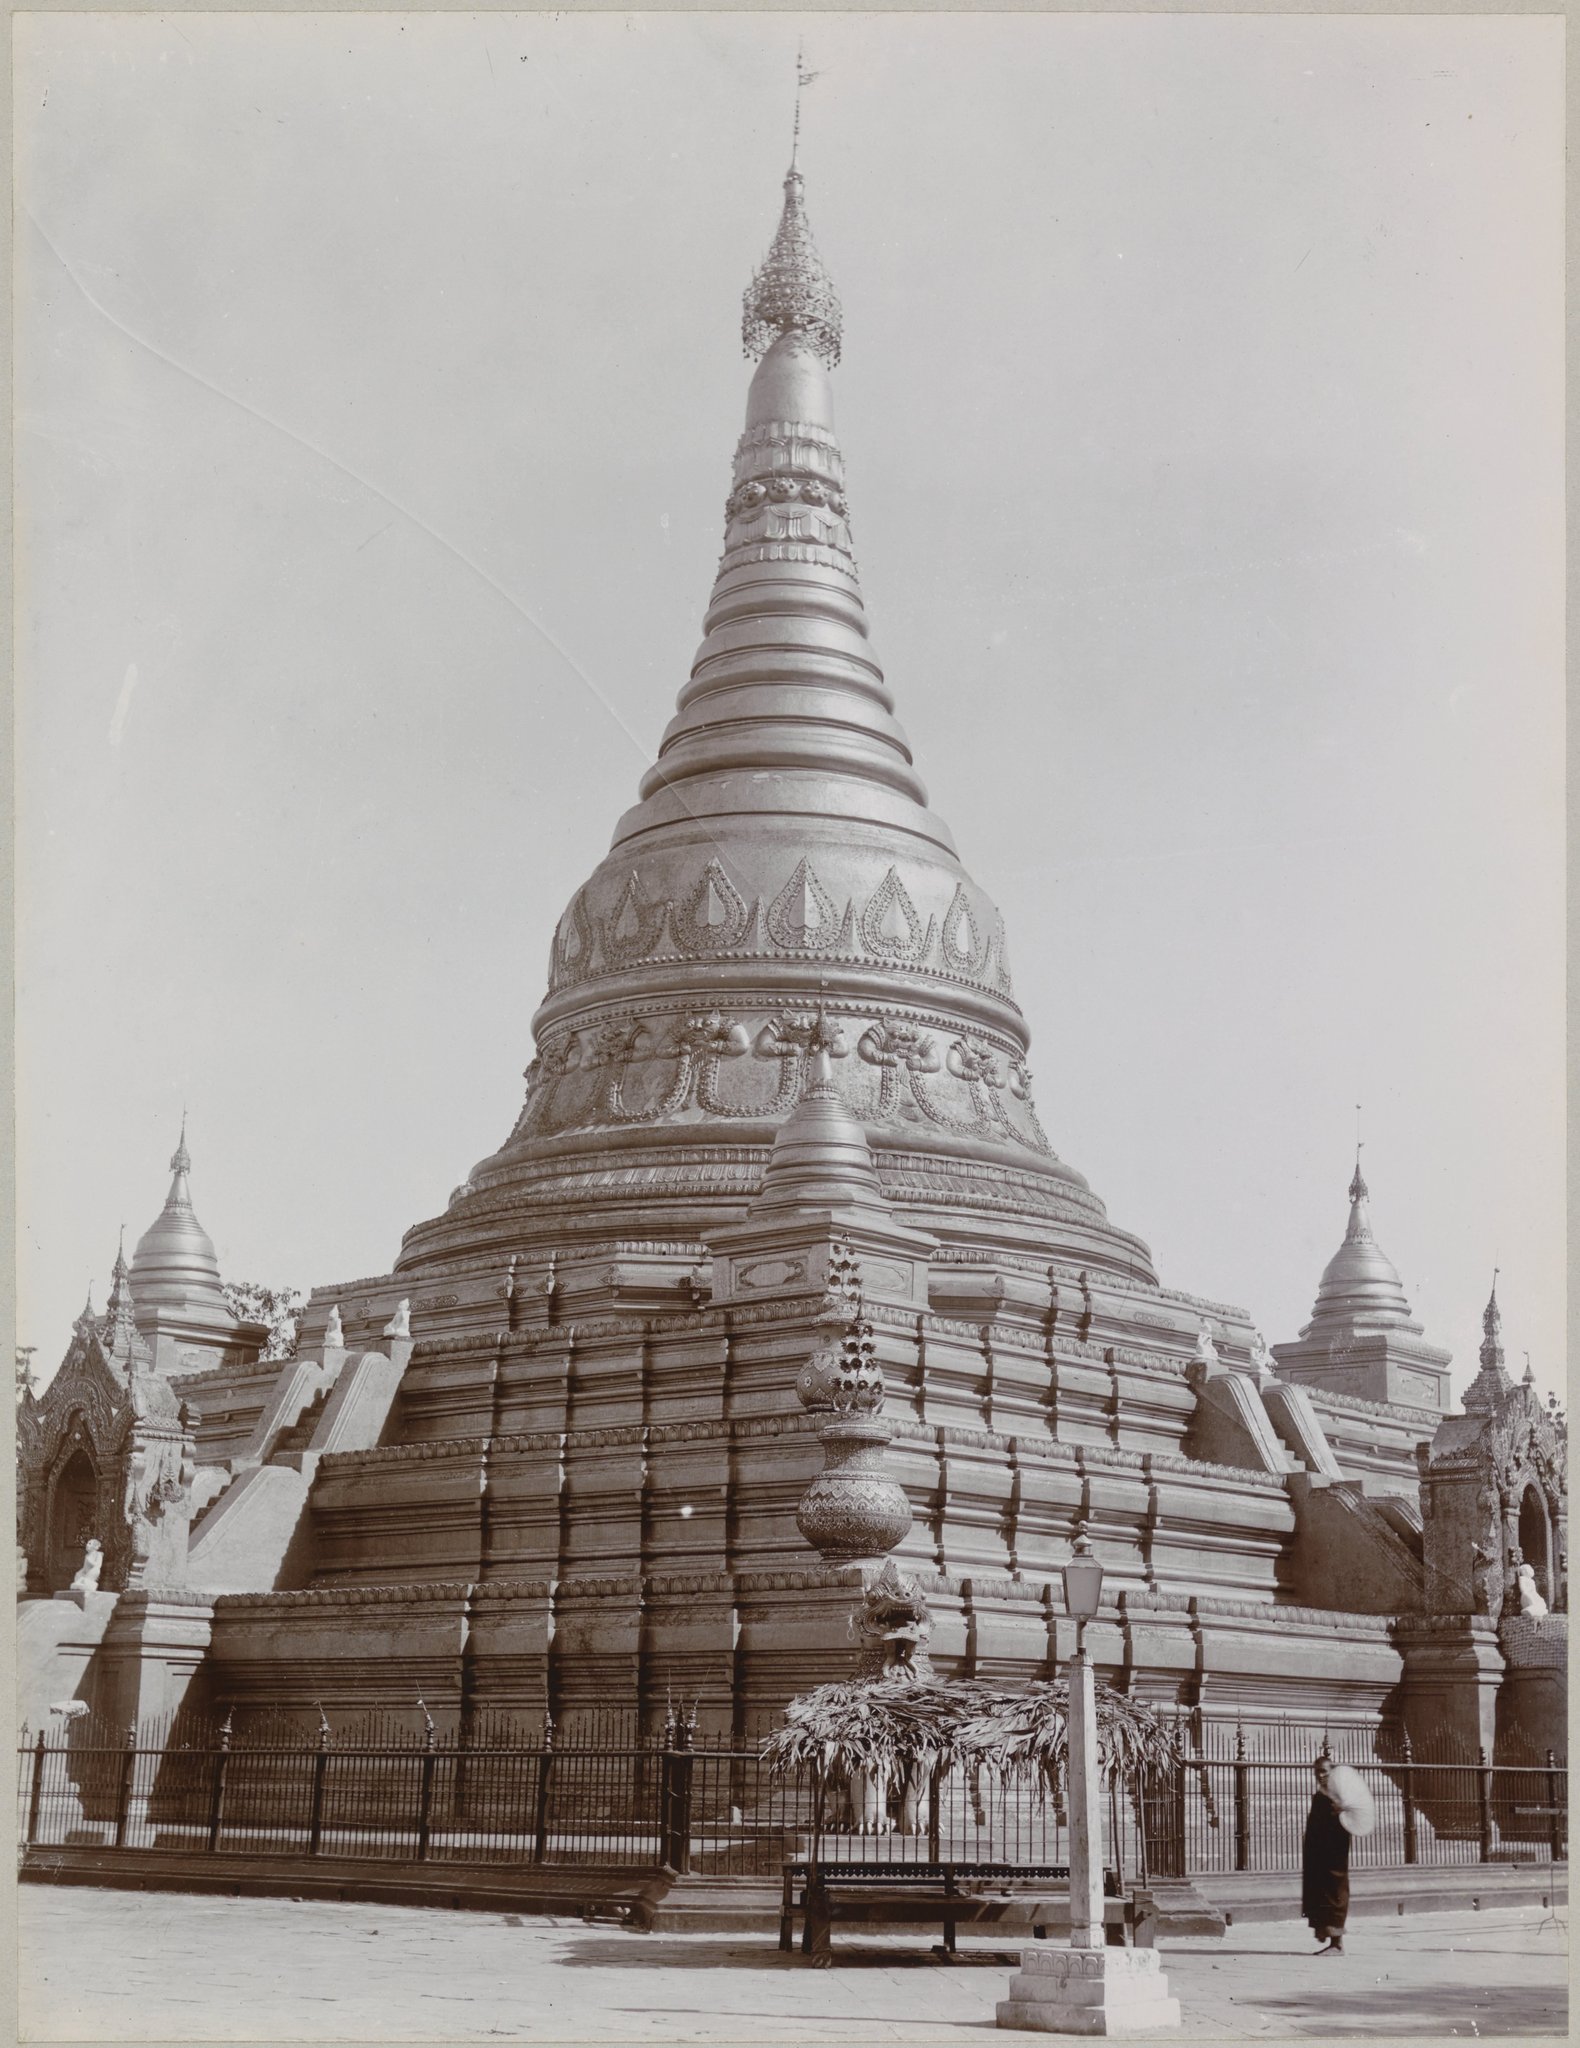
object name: photograph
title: Indoya pagoda, Mandalay, Myanmar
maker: Anonymous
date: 1895-1915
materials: cardboard, paper, photographic support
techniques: collodion silver print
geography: mandalay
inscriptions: inscription: ‘13. Mandalay: the Indoya pagoda’